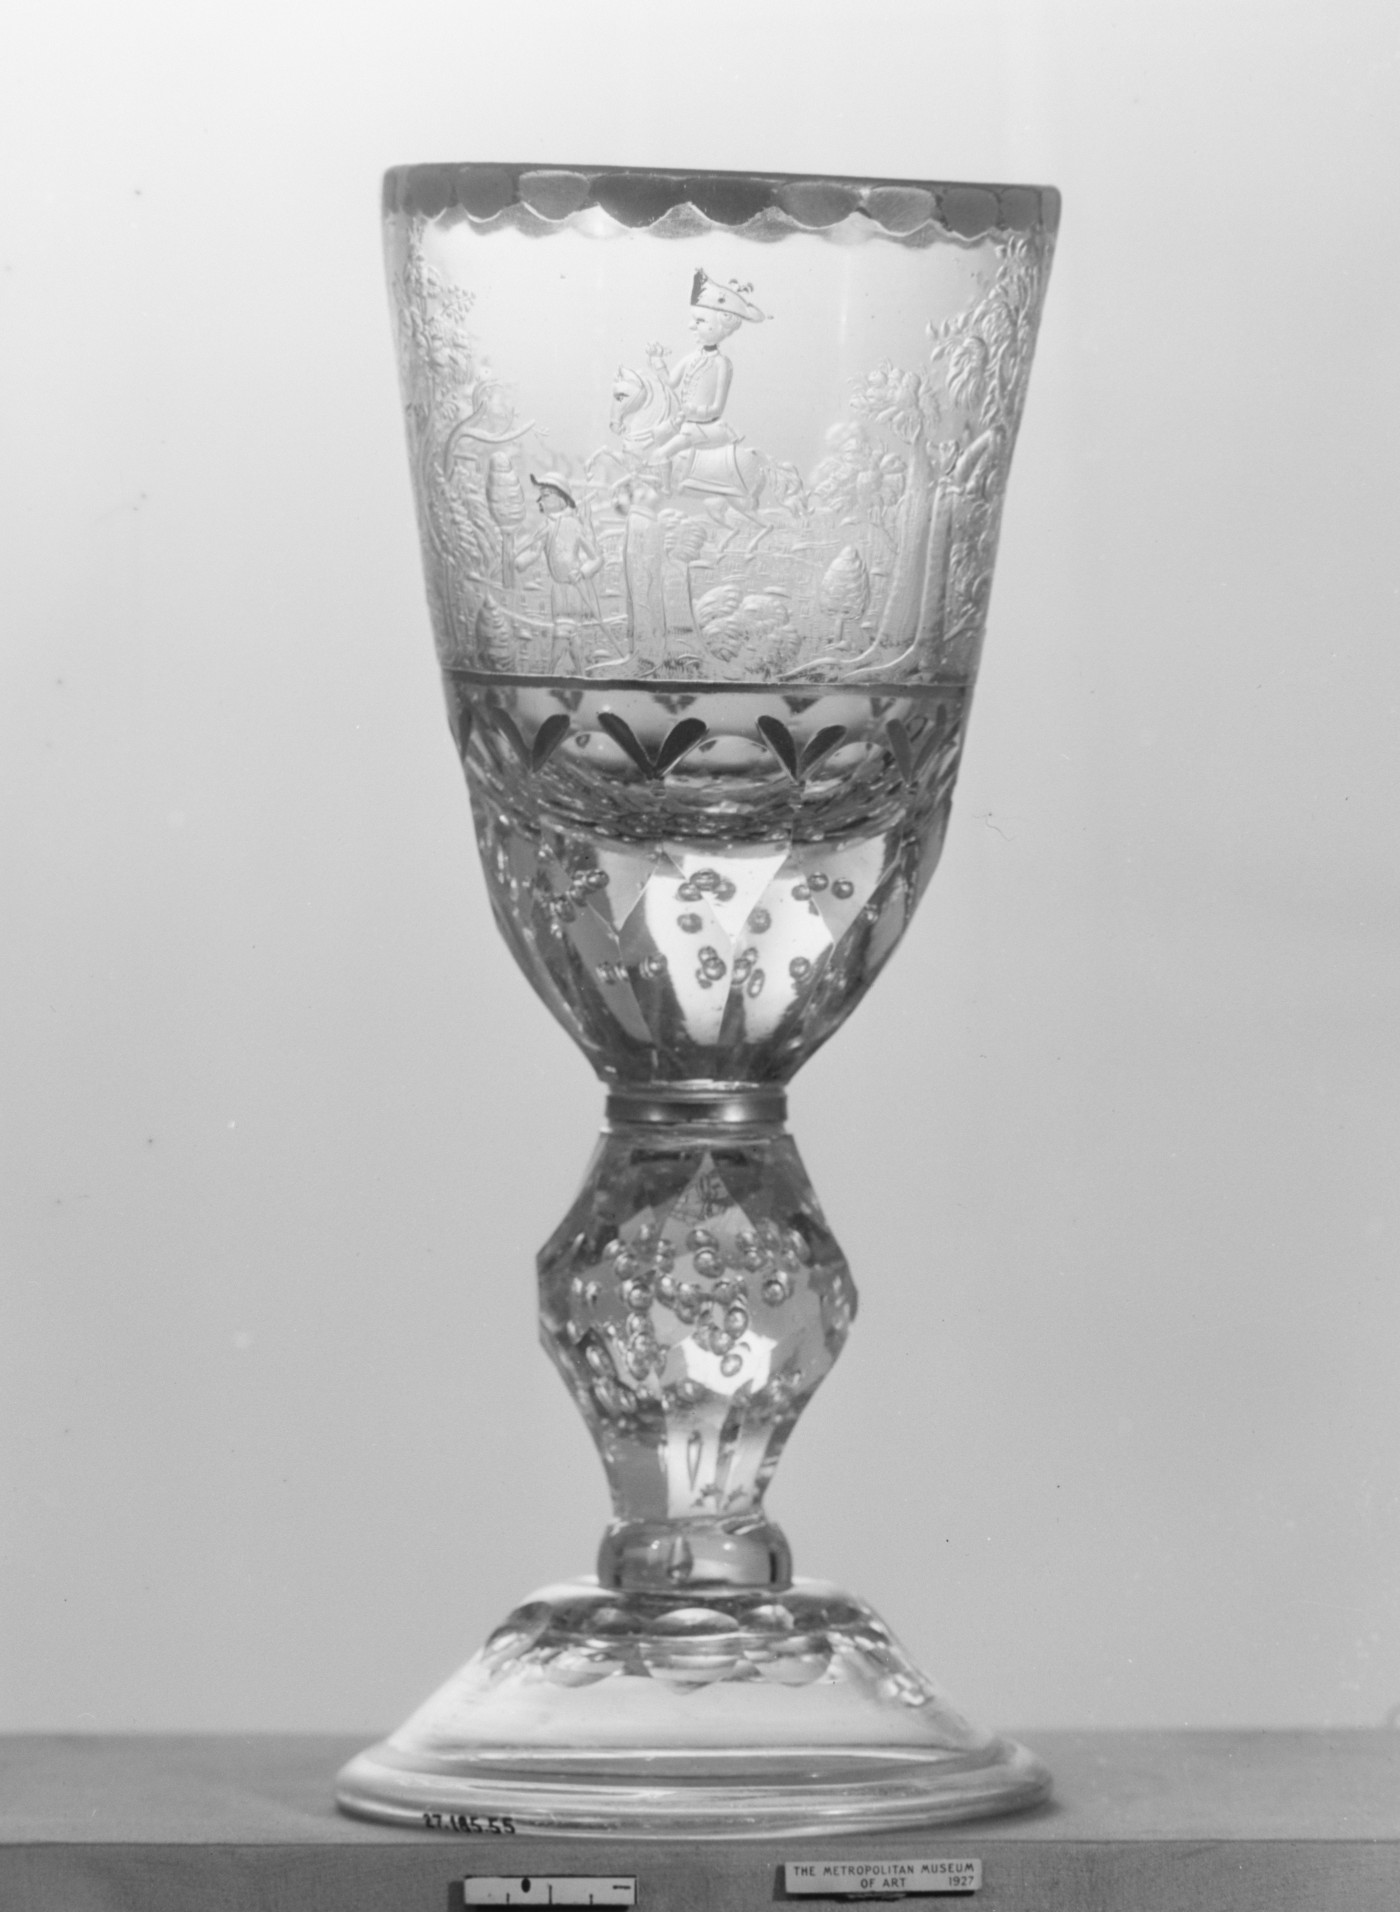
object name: standing cup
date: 1750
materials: glass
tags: men,horses